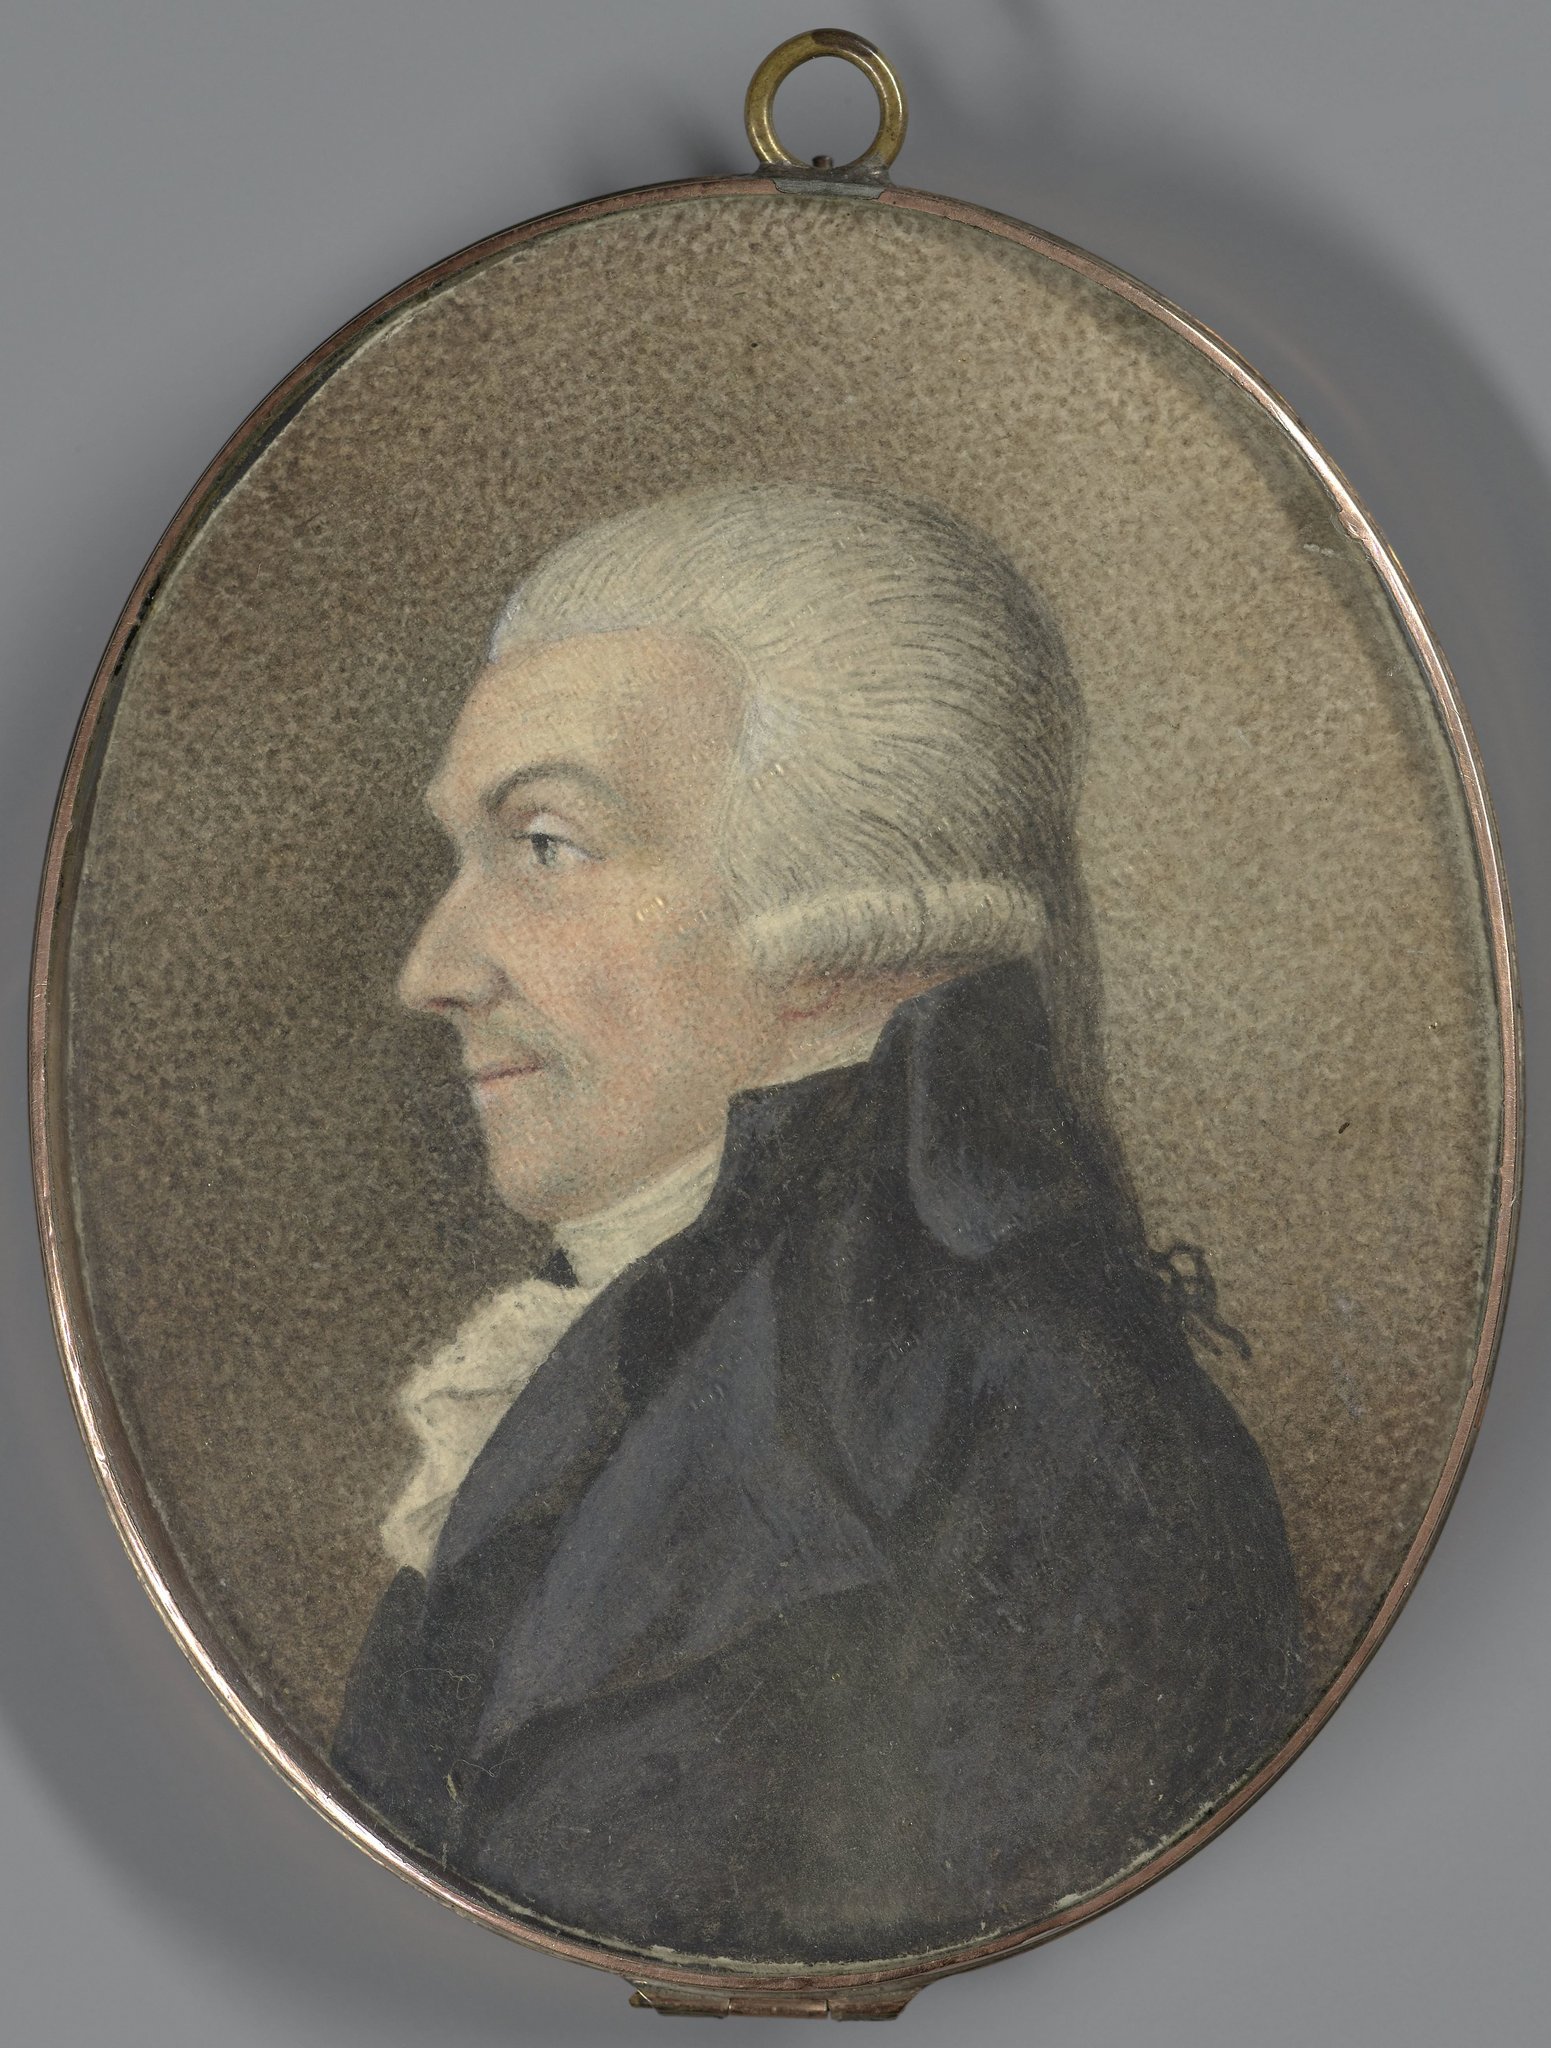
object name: painting, miniature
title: Arend Willem Baron van Reede en zijn zoon Willem Frederik Baron van Reede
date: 1800-1830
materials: cardboard, copper, glass, watercolor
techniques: aquarelle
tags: berlin, the hague, historical persons, utrecht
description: Portraits of two men,thought to be Arend Willem Baron Van Reede, (1747 - 1815), Adjutant-General of the Prince hereditary Stadholder, Majoor-General of the infantry and envoy in Berlin, and on the verso his son Willem Frederik Baron (Count from 1822) Van Reede, (1770 - 1838), Minister of Foreign Affairs and Chairman of the First Chamber of the States General. Northern Netherlands school. Board, c. 1795.